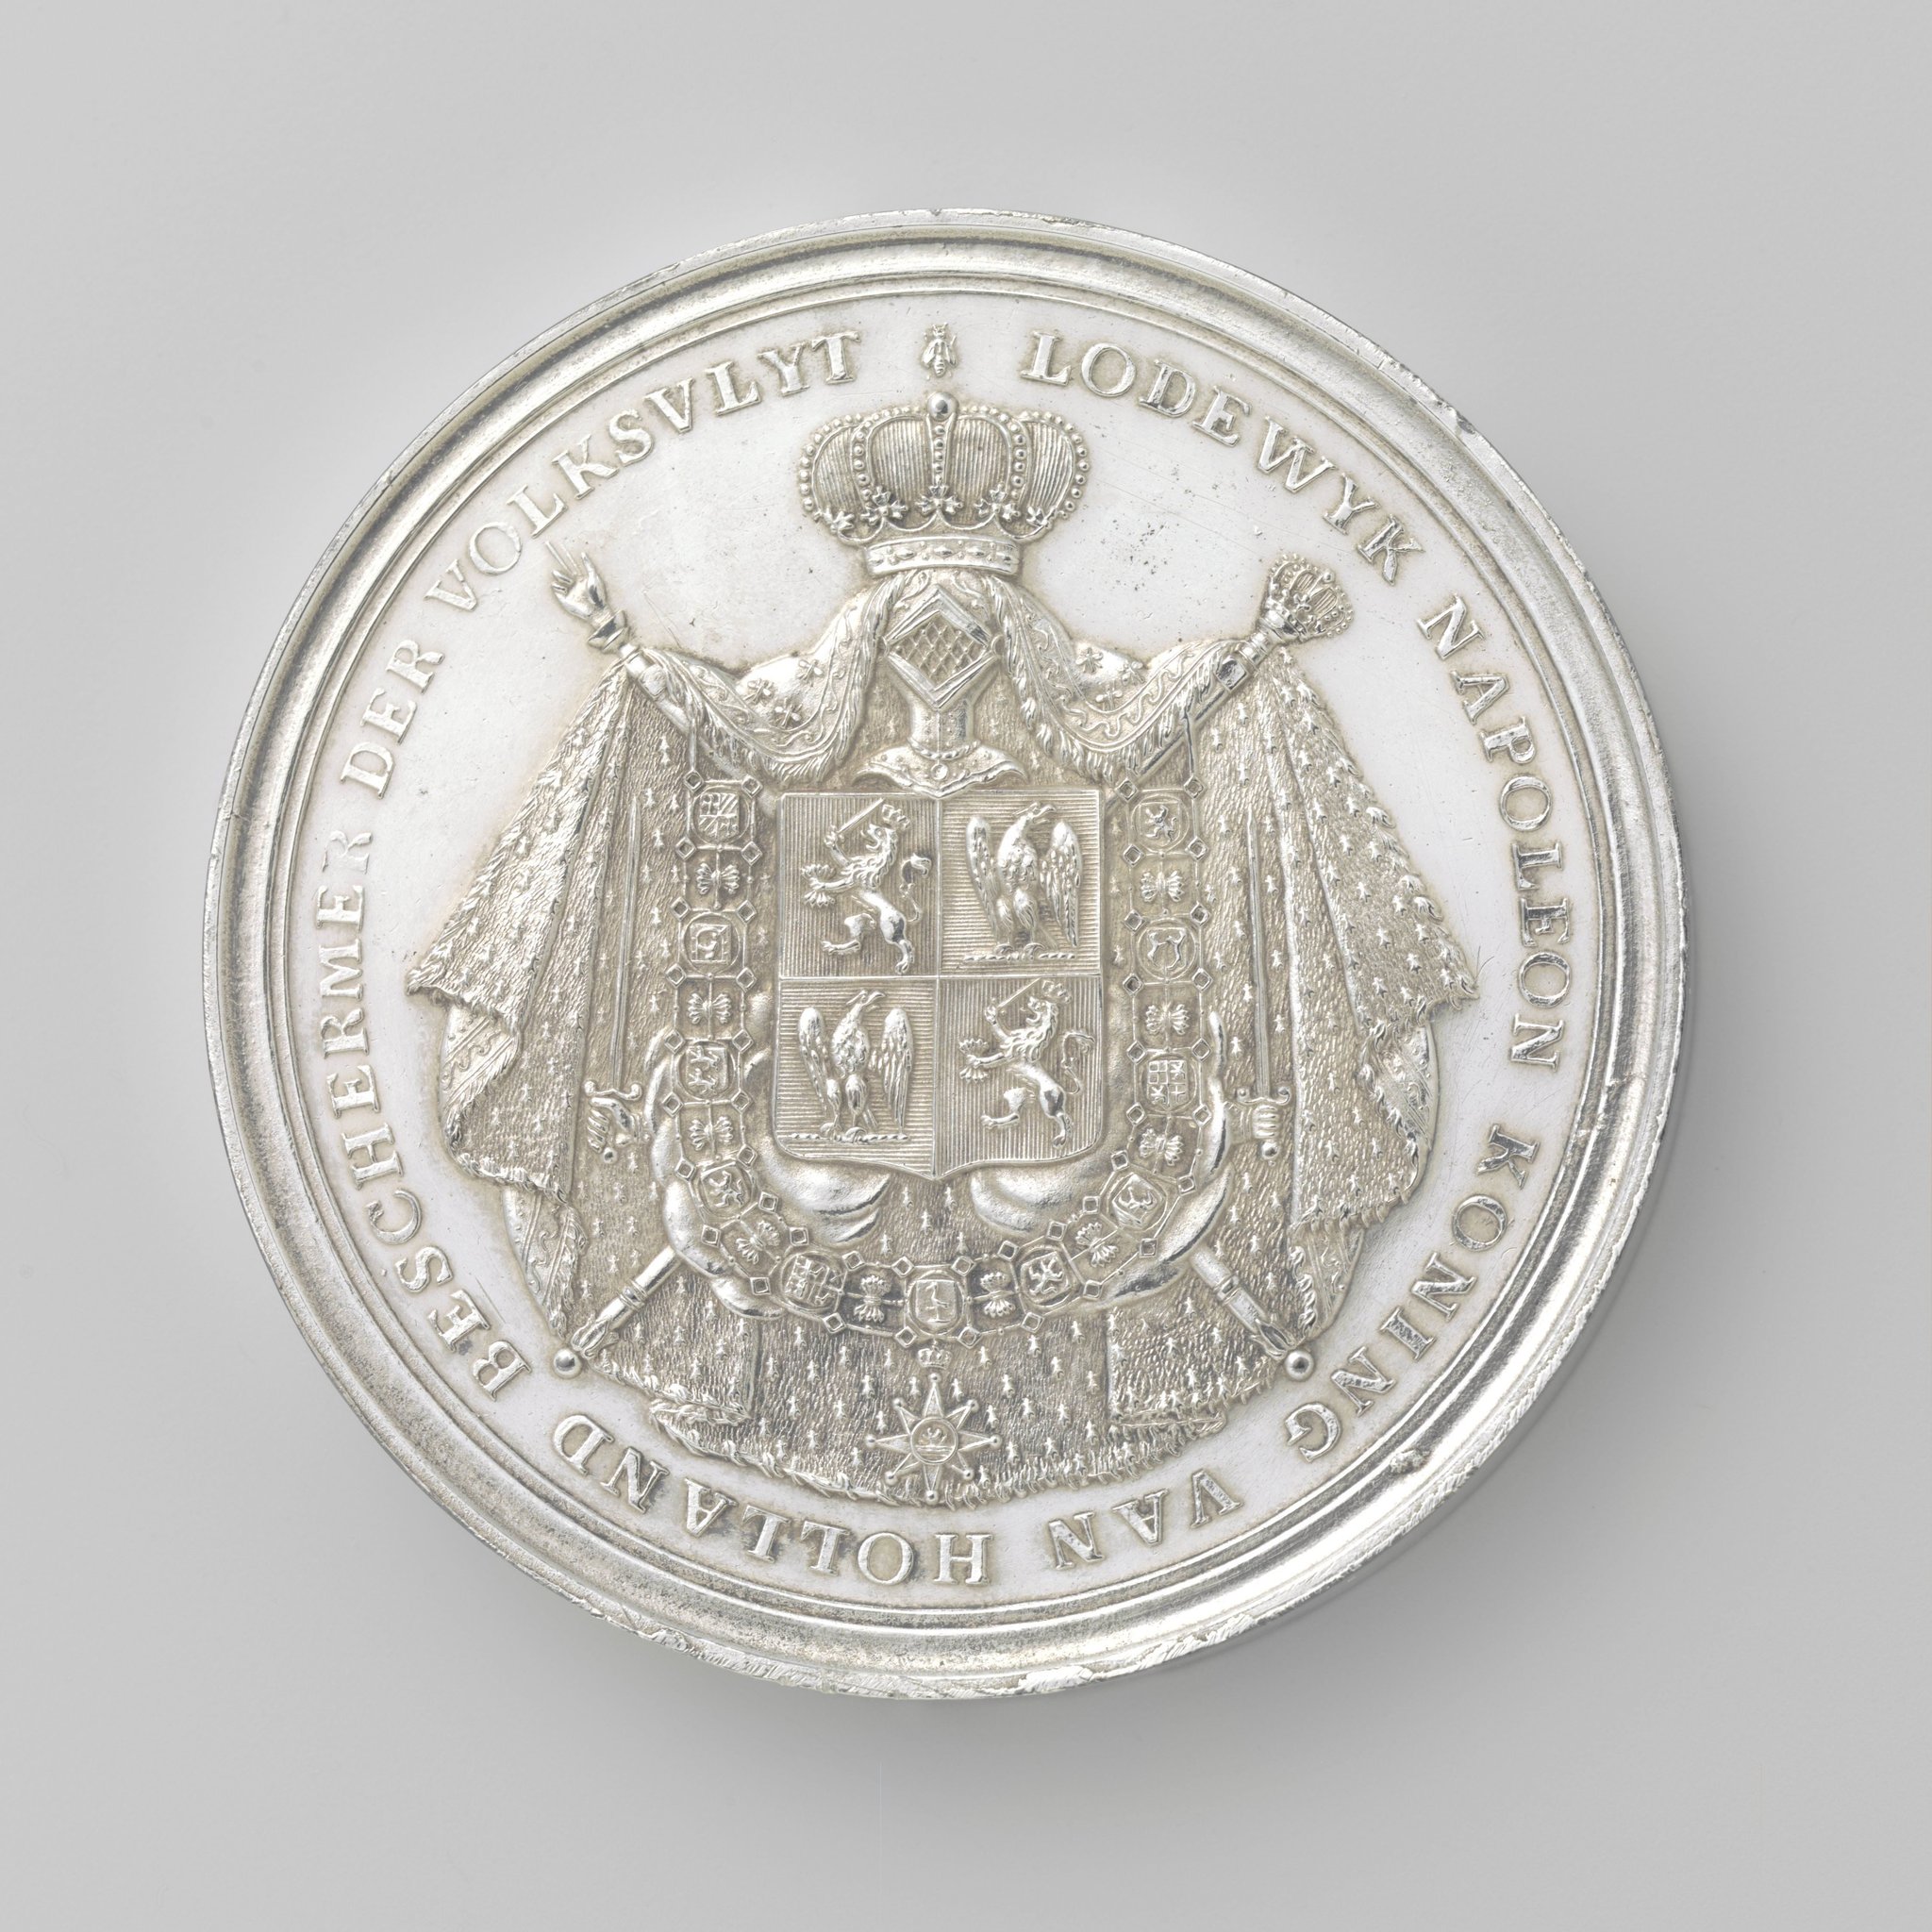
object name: medal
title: Beloning van Hollandse Nijverheid voor Dommer & Comp. Porseleinfabriek aan den Amsel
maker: h. de heus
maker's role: wapensmid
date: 1808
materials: silver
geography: netherlands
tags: louis napoleon (king of holland), porcelain company, utrecht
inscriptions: date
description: Medal. Silver, c. 1808, designed by H. de Heus. Awarded to Dommer's porcelain factory for its display at the General Public Exhibition of the Products of Dutch Industry at Utrecht in 1808. Given by C.J. Ihle on behalf of the firm De Weduwe George Dommer & Co.